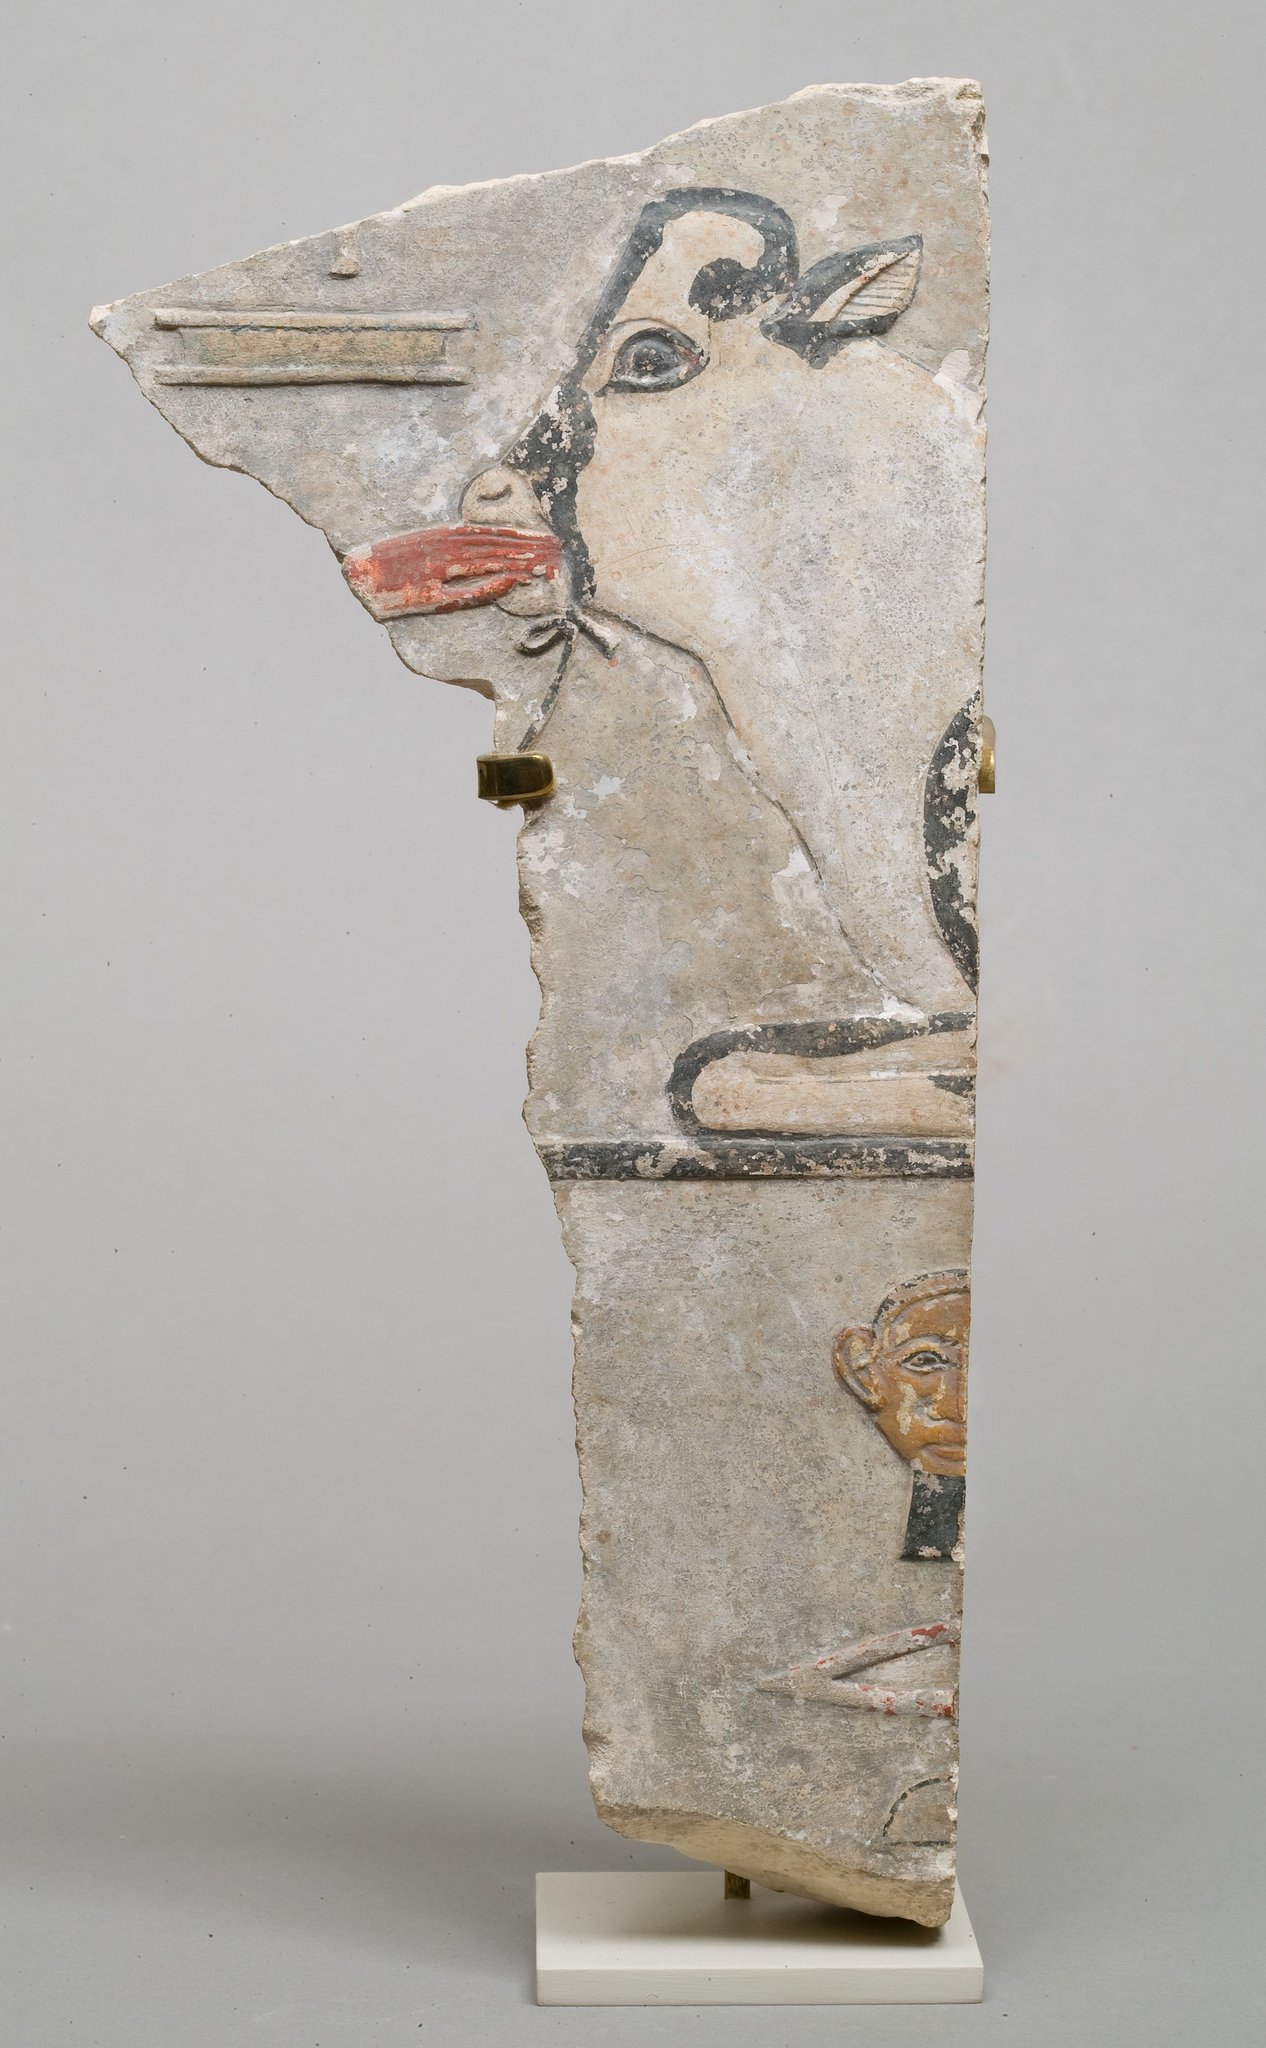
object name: relief fragment, cow being force fed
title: Relief fragment from tomb of Senwosret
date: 1925-1900 BCE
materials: limestone, paint, plaster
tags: animals,tombs